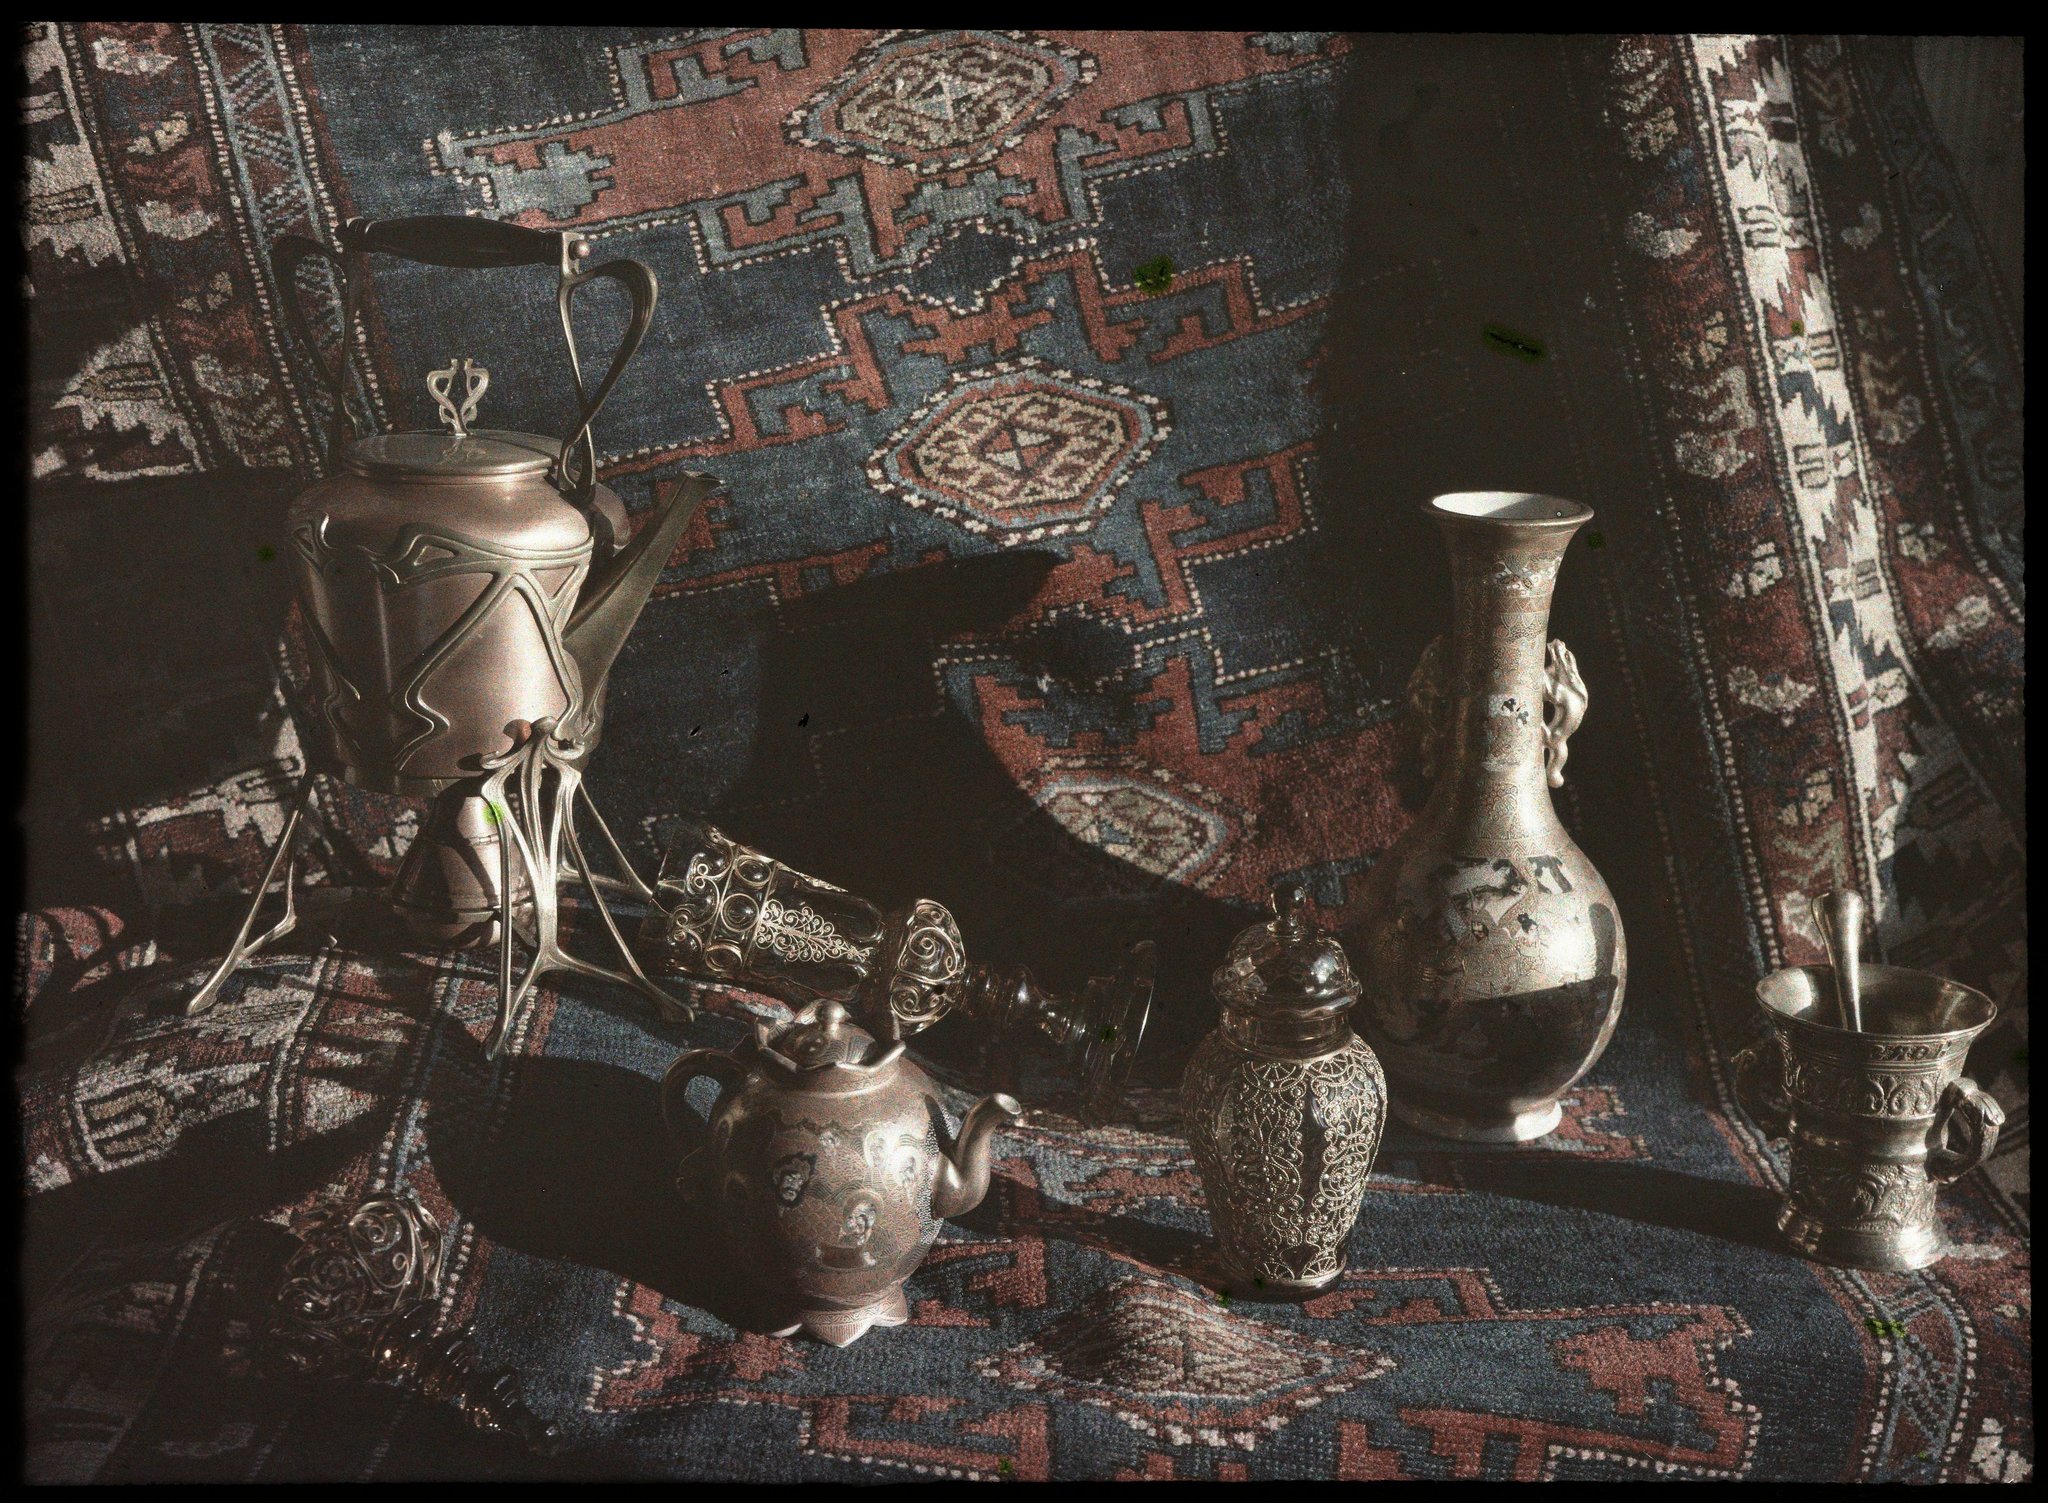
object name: glasdia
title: Stilleven van aardewerken, koperen en tinnen vazen, beker en potten op een tapijt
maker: c.w. immink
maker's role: fotograaf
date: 1907-1935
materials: glass, paper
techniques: autochrome process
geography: netherlands